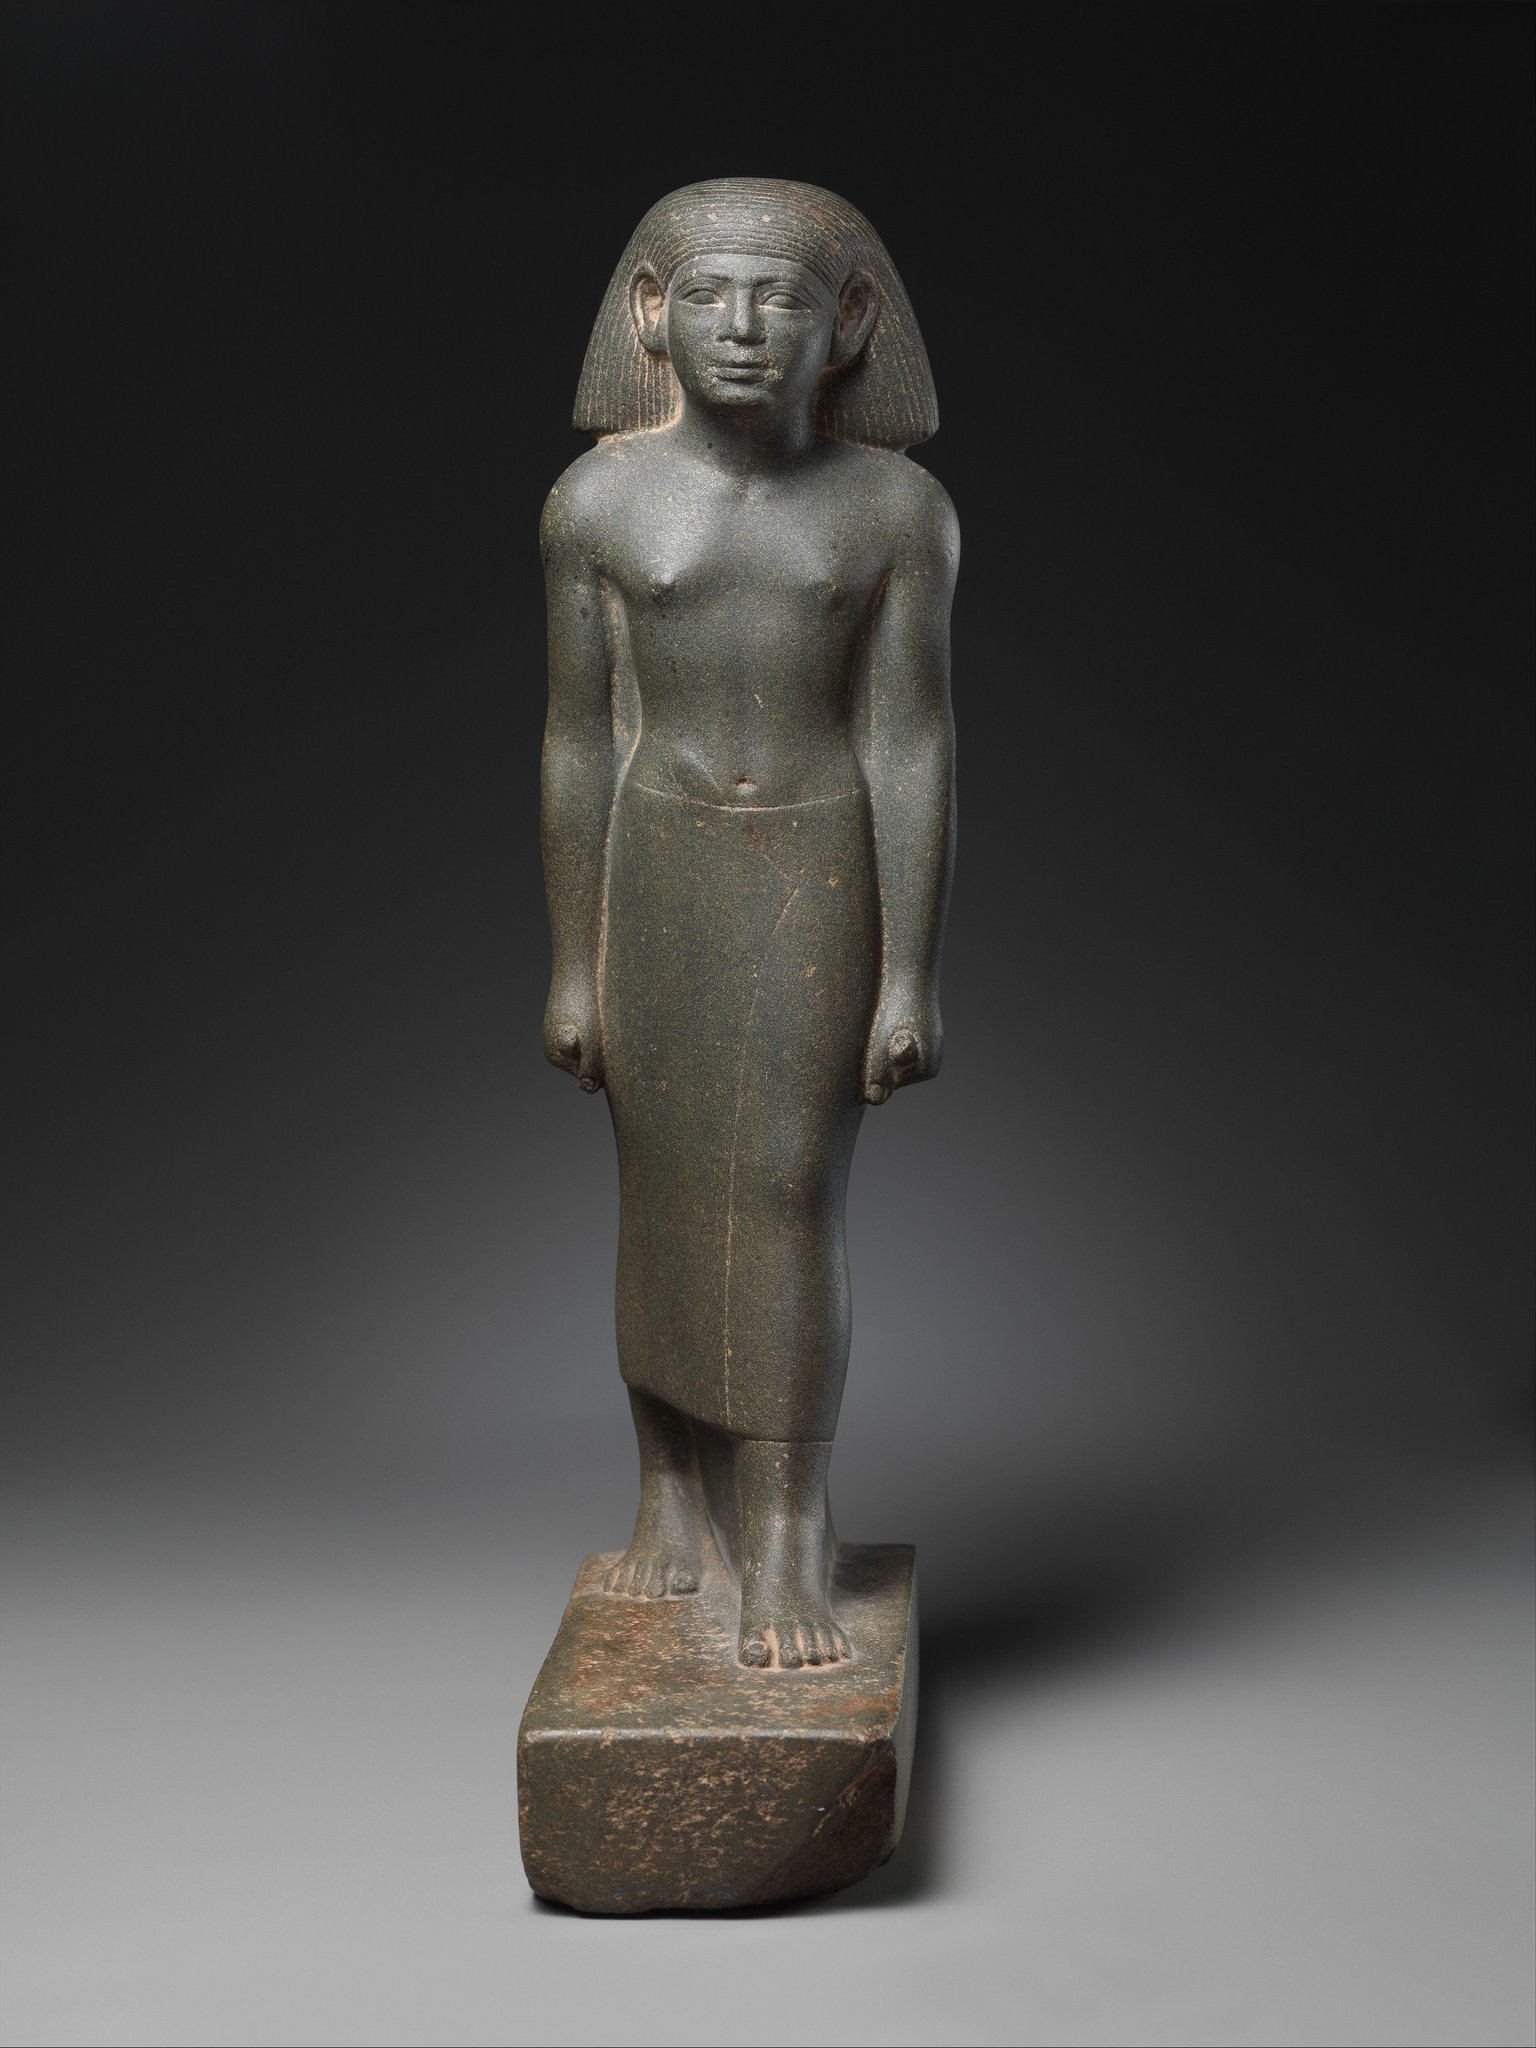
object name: statuette, striding man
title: Statuette of a striding man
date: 1919-1878 BCE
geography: egypt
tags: men